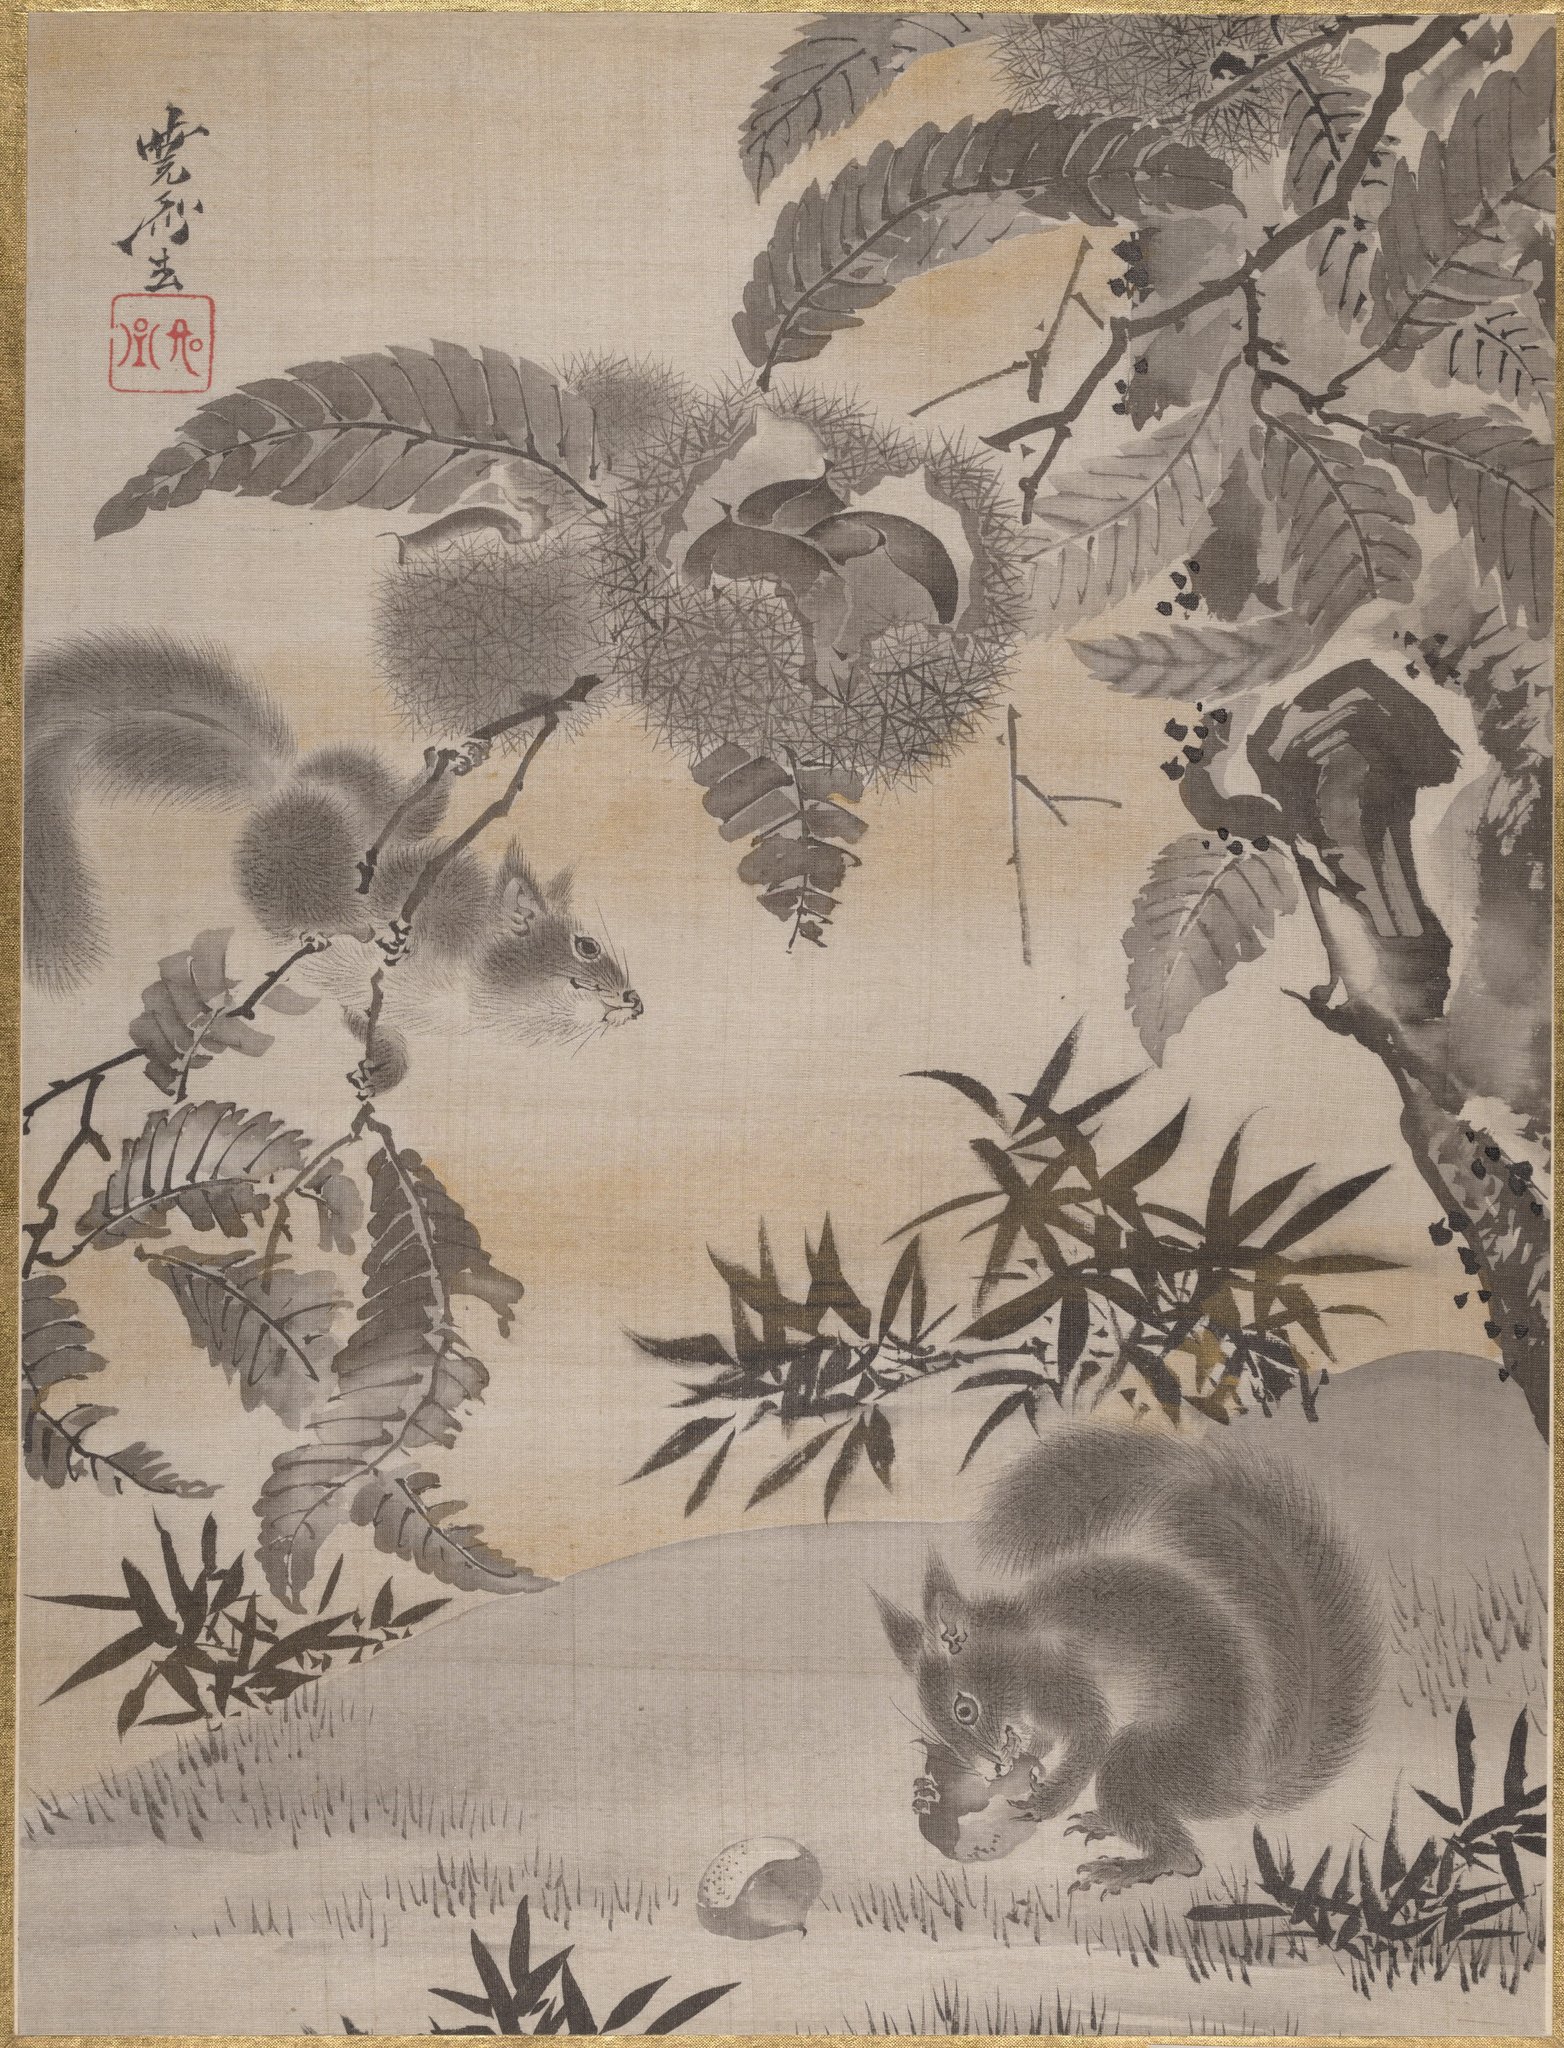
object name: album leaf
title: Squirrels Gathering Chestnuts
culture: japanese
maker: kawanabe kyōsai 河鍋暁斎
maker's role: artist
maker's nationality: japanese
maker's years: 1831-1889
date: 1887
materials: gold, ink, silk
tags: squirrels